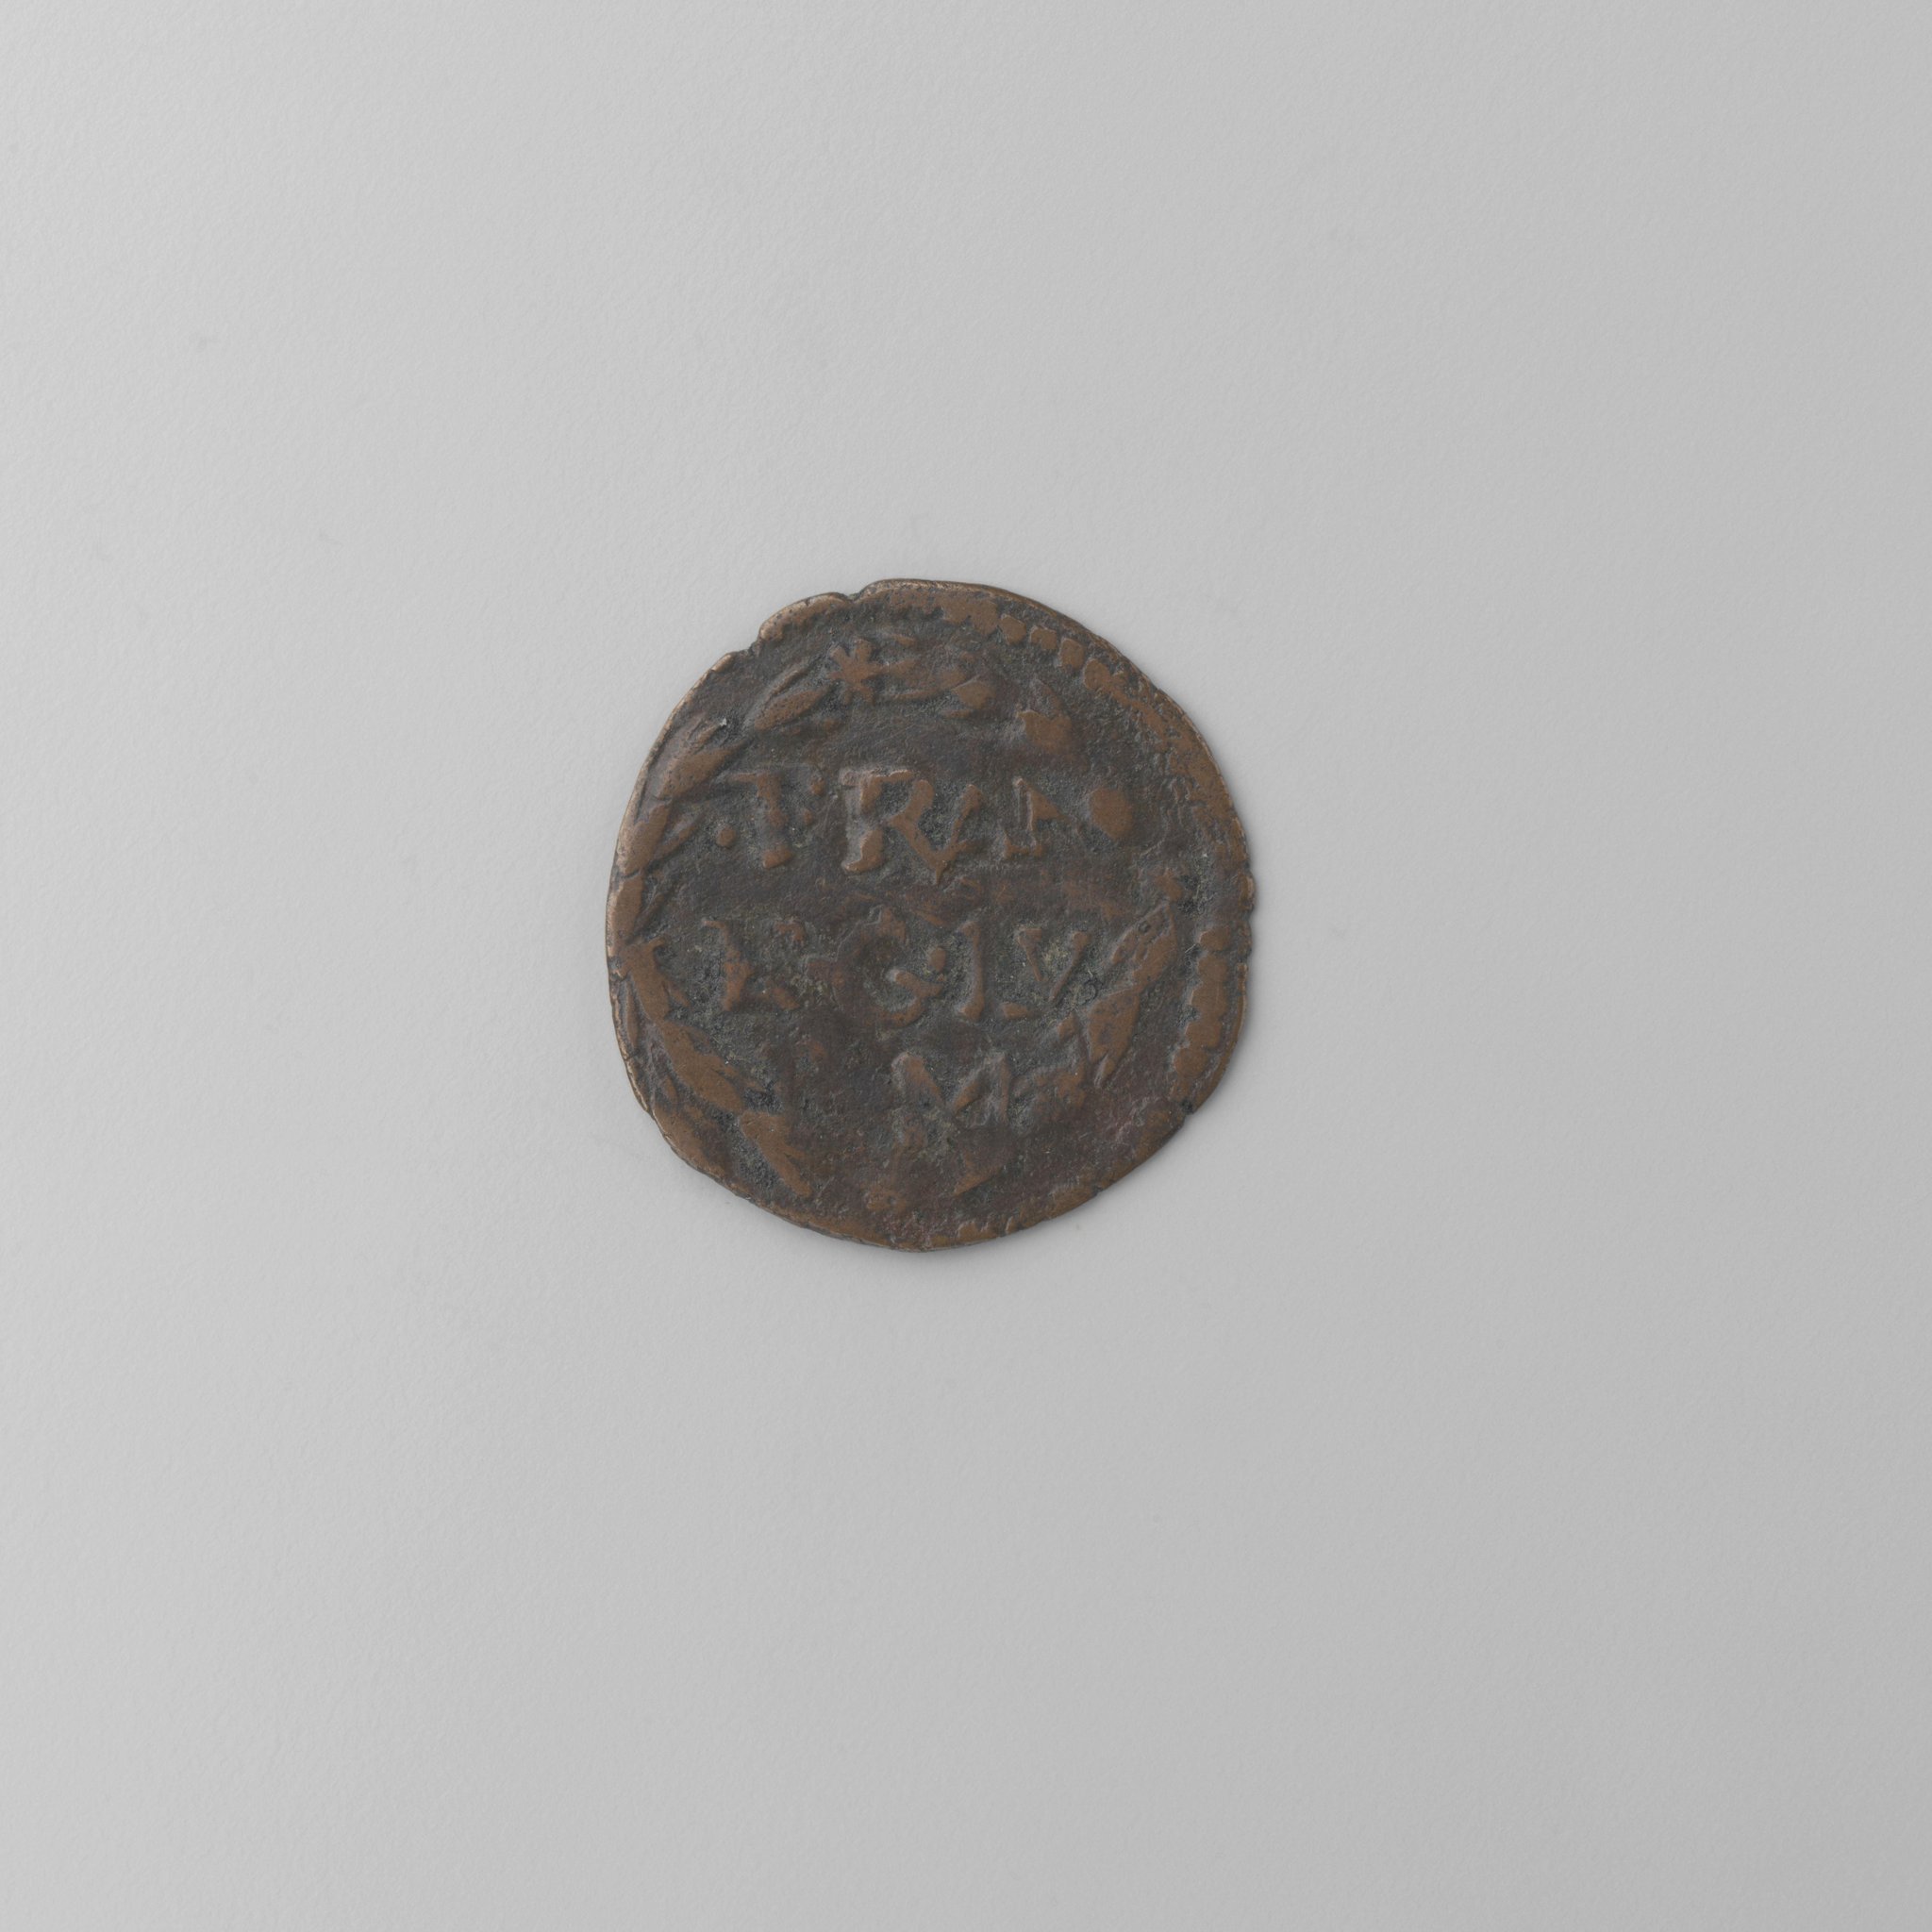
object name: coin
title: Reckheimse duit van Francois Gobert en Ferdinand Gobert van Aspremont-Lynden (1665-1703)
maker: heer van reckheim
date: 1665-1703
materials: copper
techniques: striking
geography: rekem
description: Koperen munt. Voorzijde: versierd wapenschild. Keerzijde: binnen een krans drie-regelig opschrift.